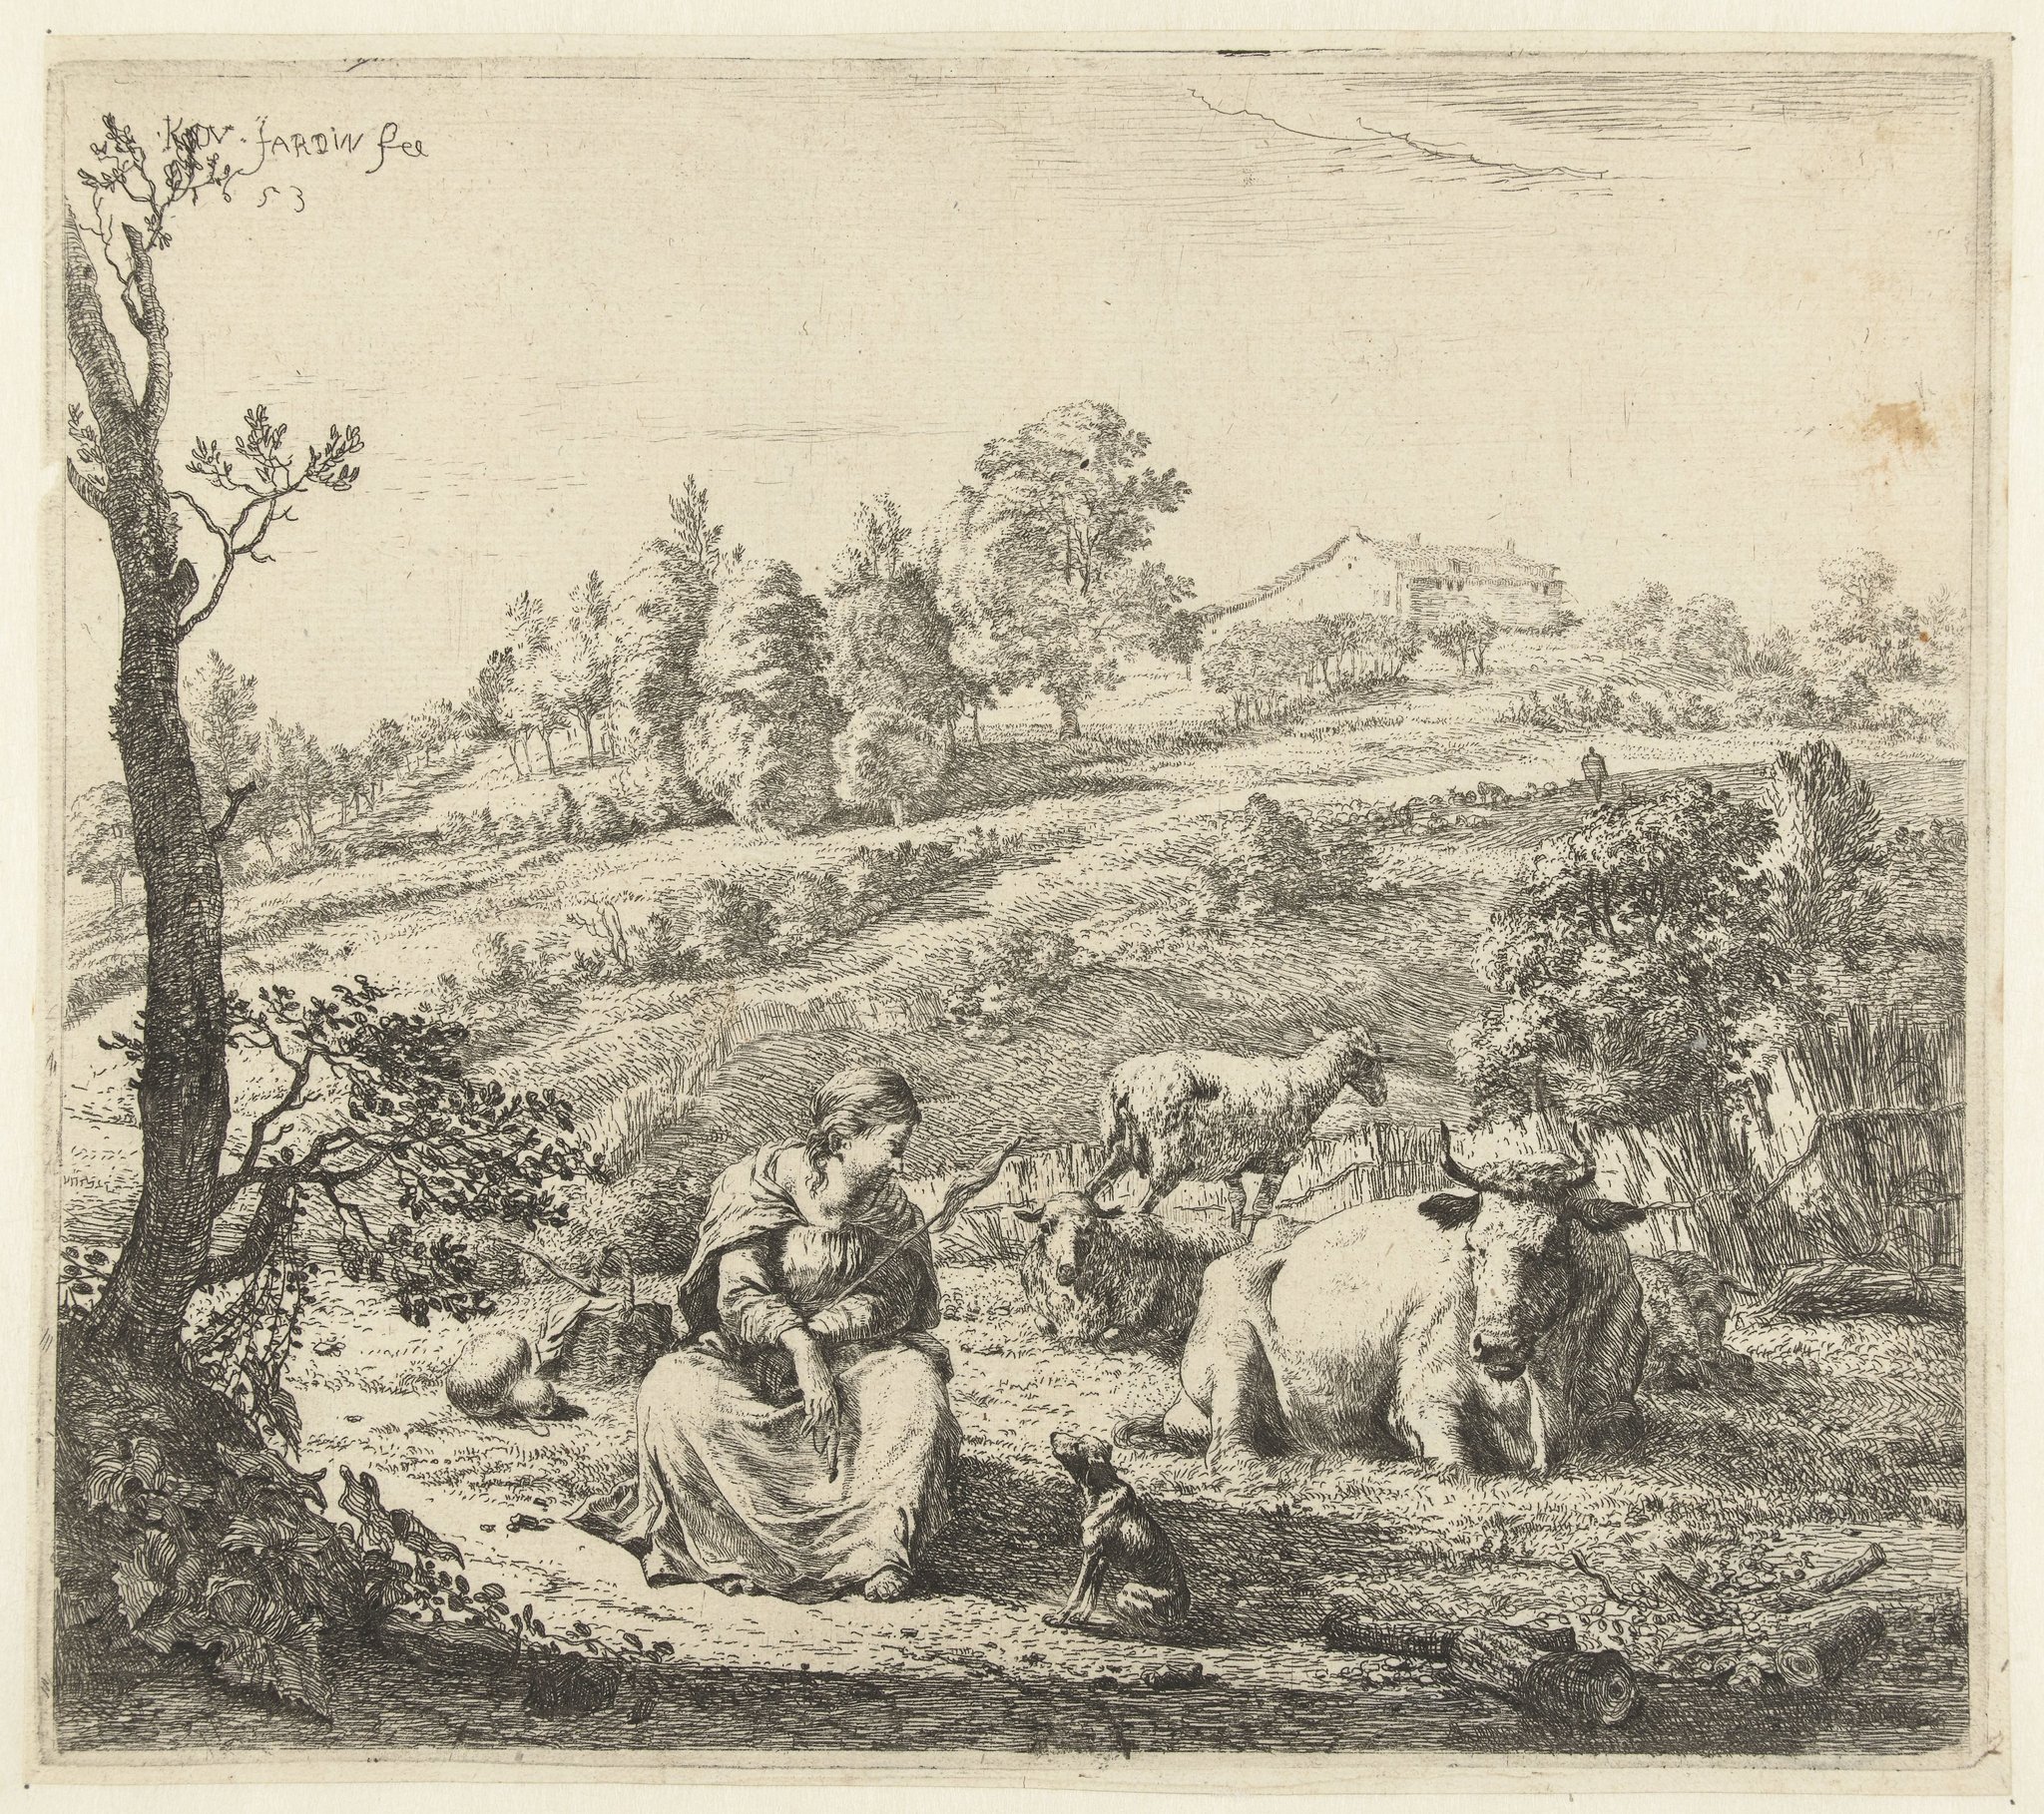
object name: print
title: Heuvellandschap met herderin en hond bij rustende kudde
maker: karel du jardin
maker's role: draughtsman, painter, print maker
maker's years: 1626-1678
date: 1653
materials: paper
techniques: etching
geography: amsterdam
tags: cow, herding, herdsman, herdswoman, shepherd, shepherdess, cowherd, etc., sheep, dog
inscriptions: collector's mark: Lugt 10, collector's mark: Lugt 11